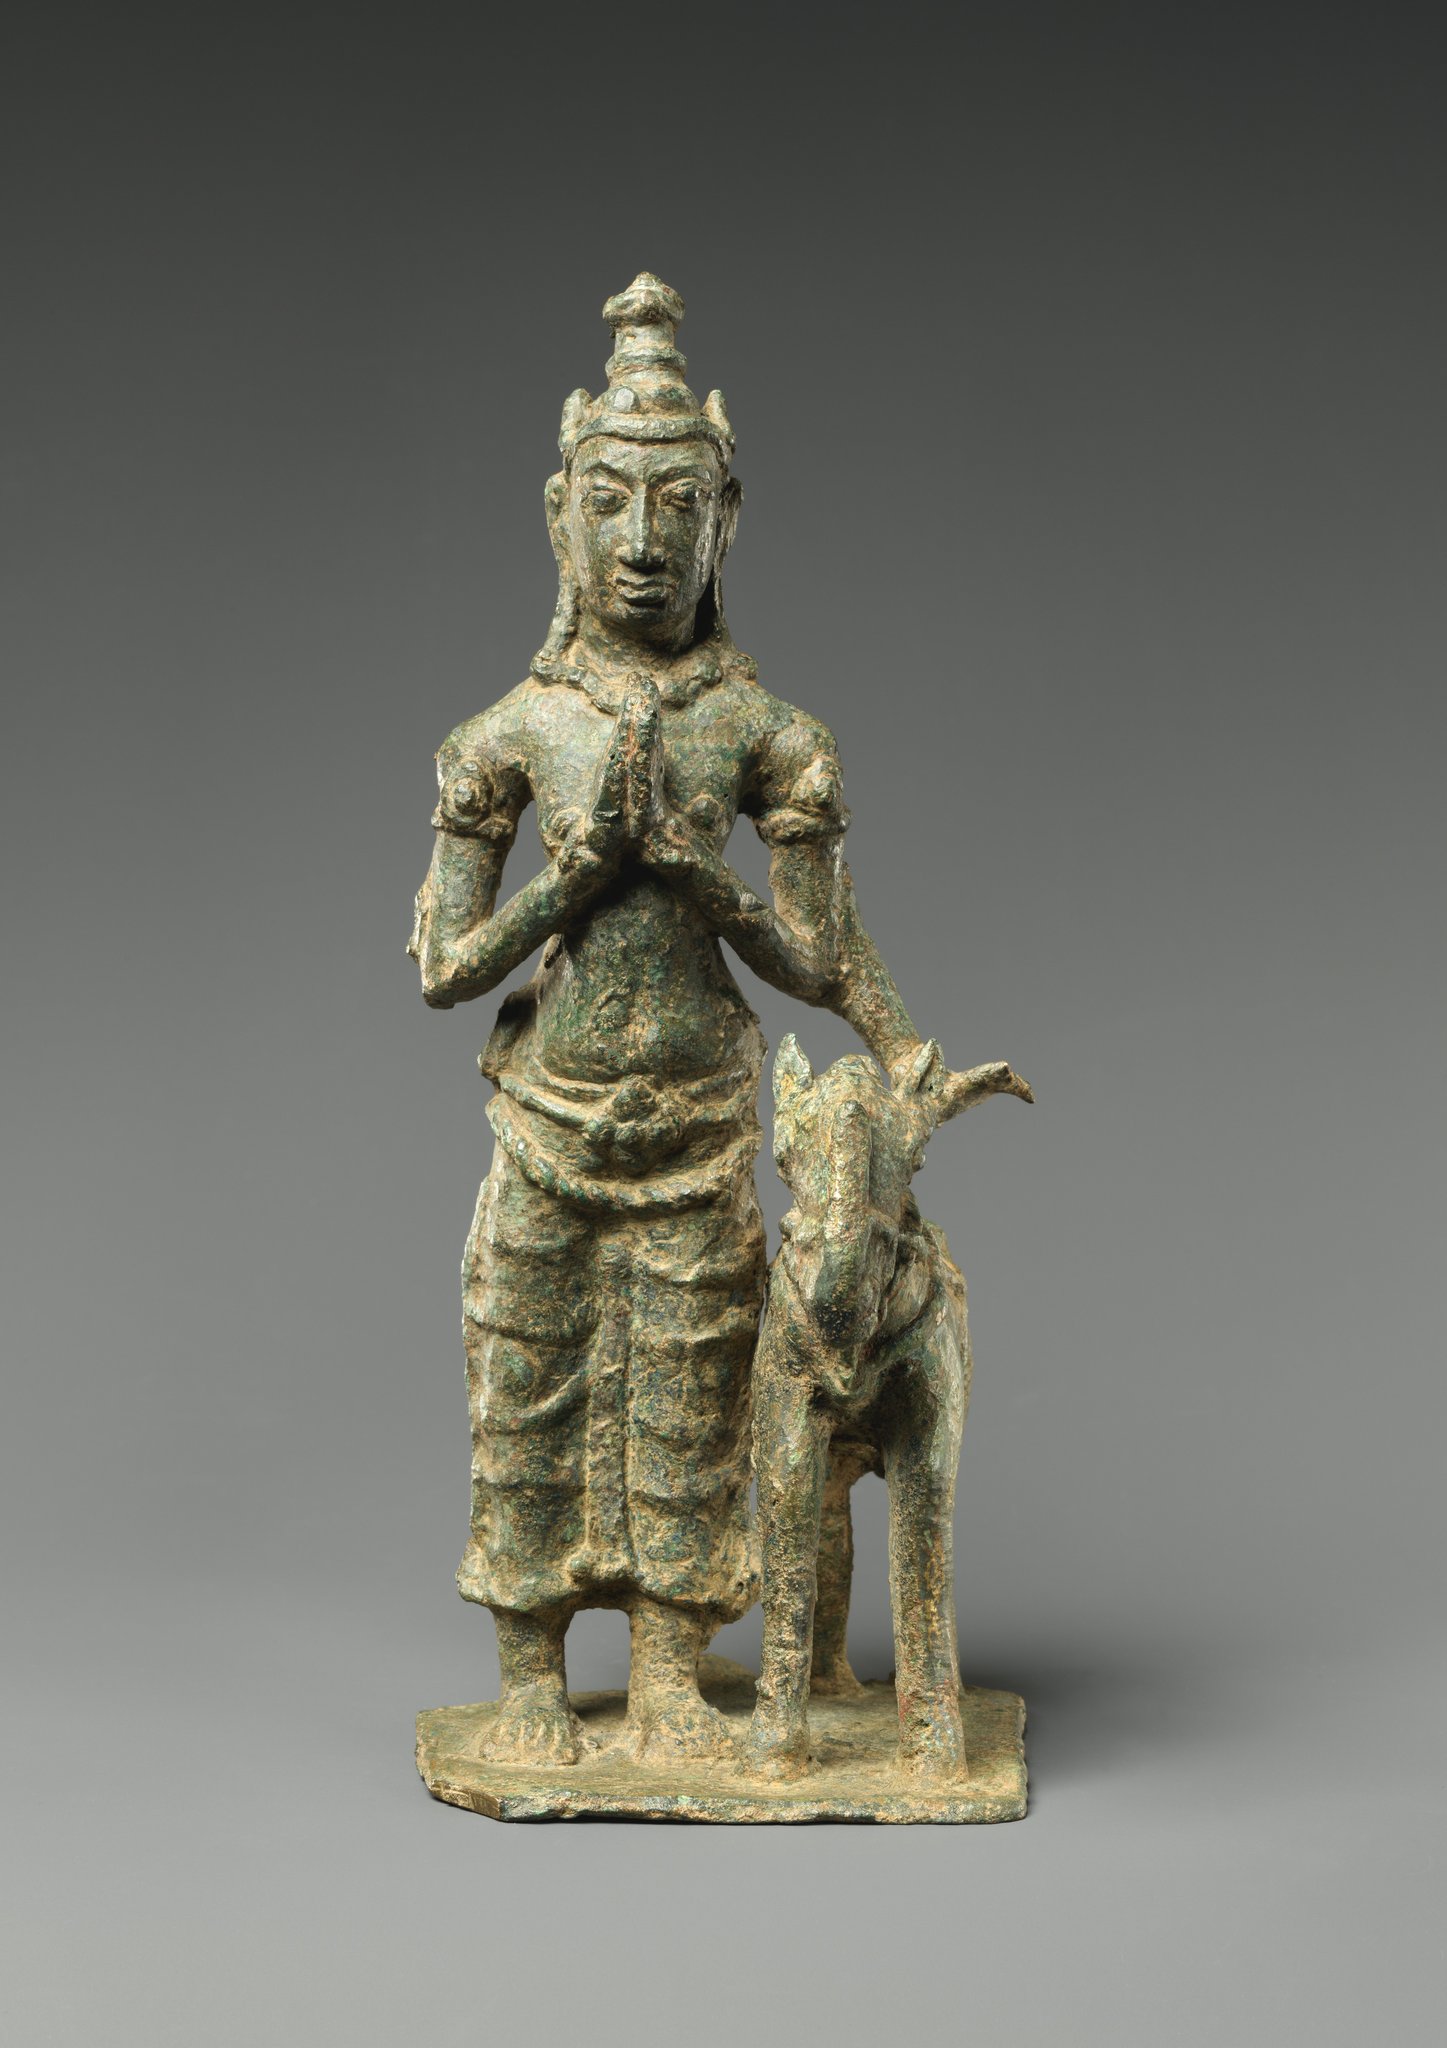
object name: lokapala figure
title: Varuna, Lord of Knowledge; Regent of the West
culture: sri lankan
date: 801-900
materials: bronze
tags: horses,deities